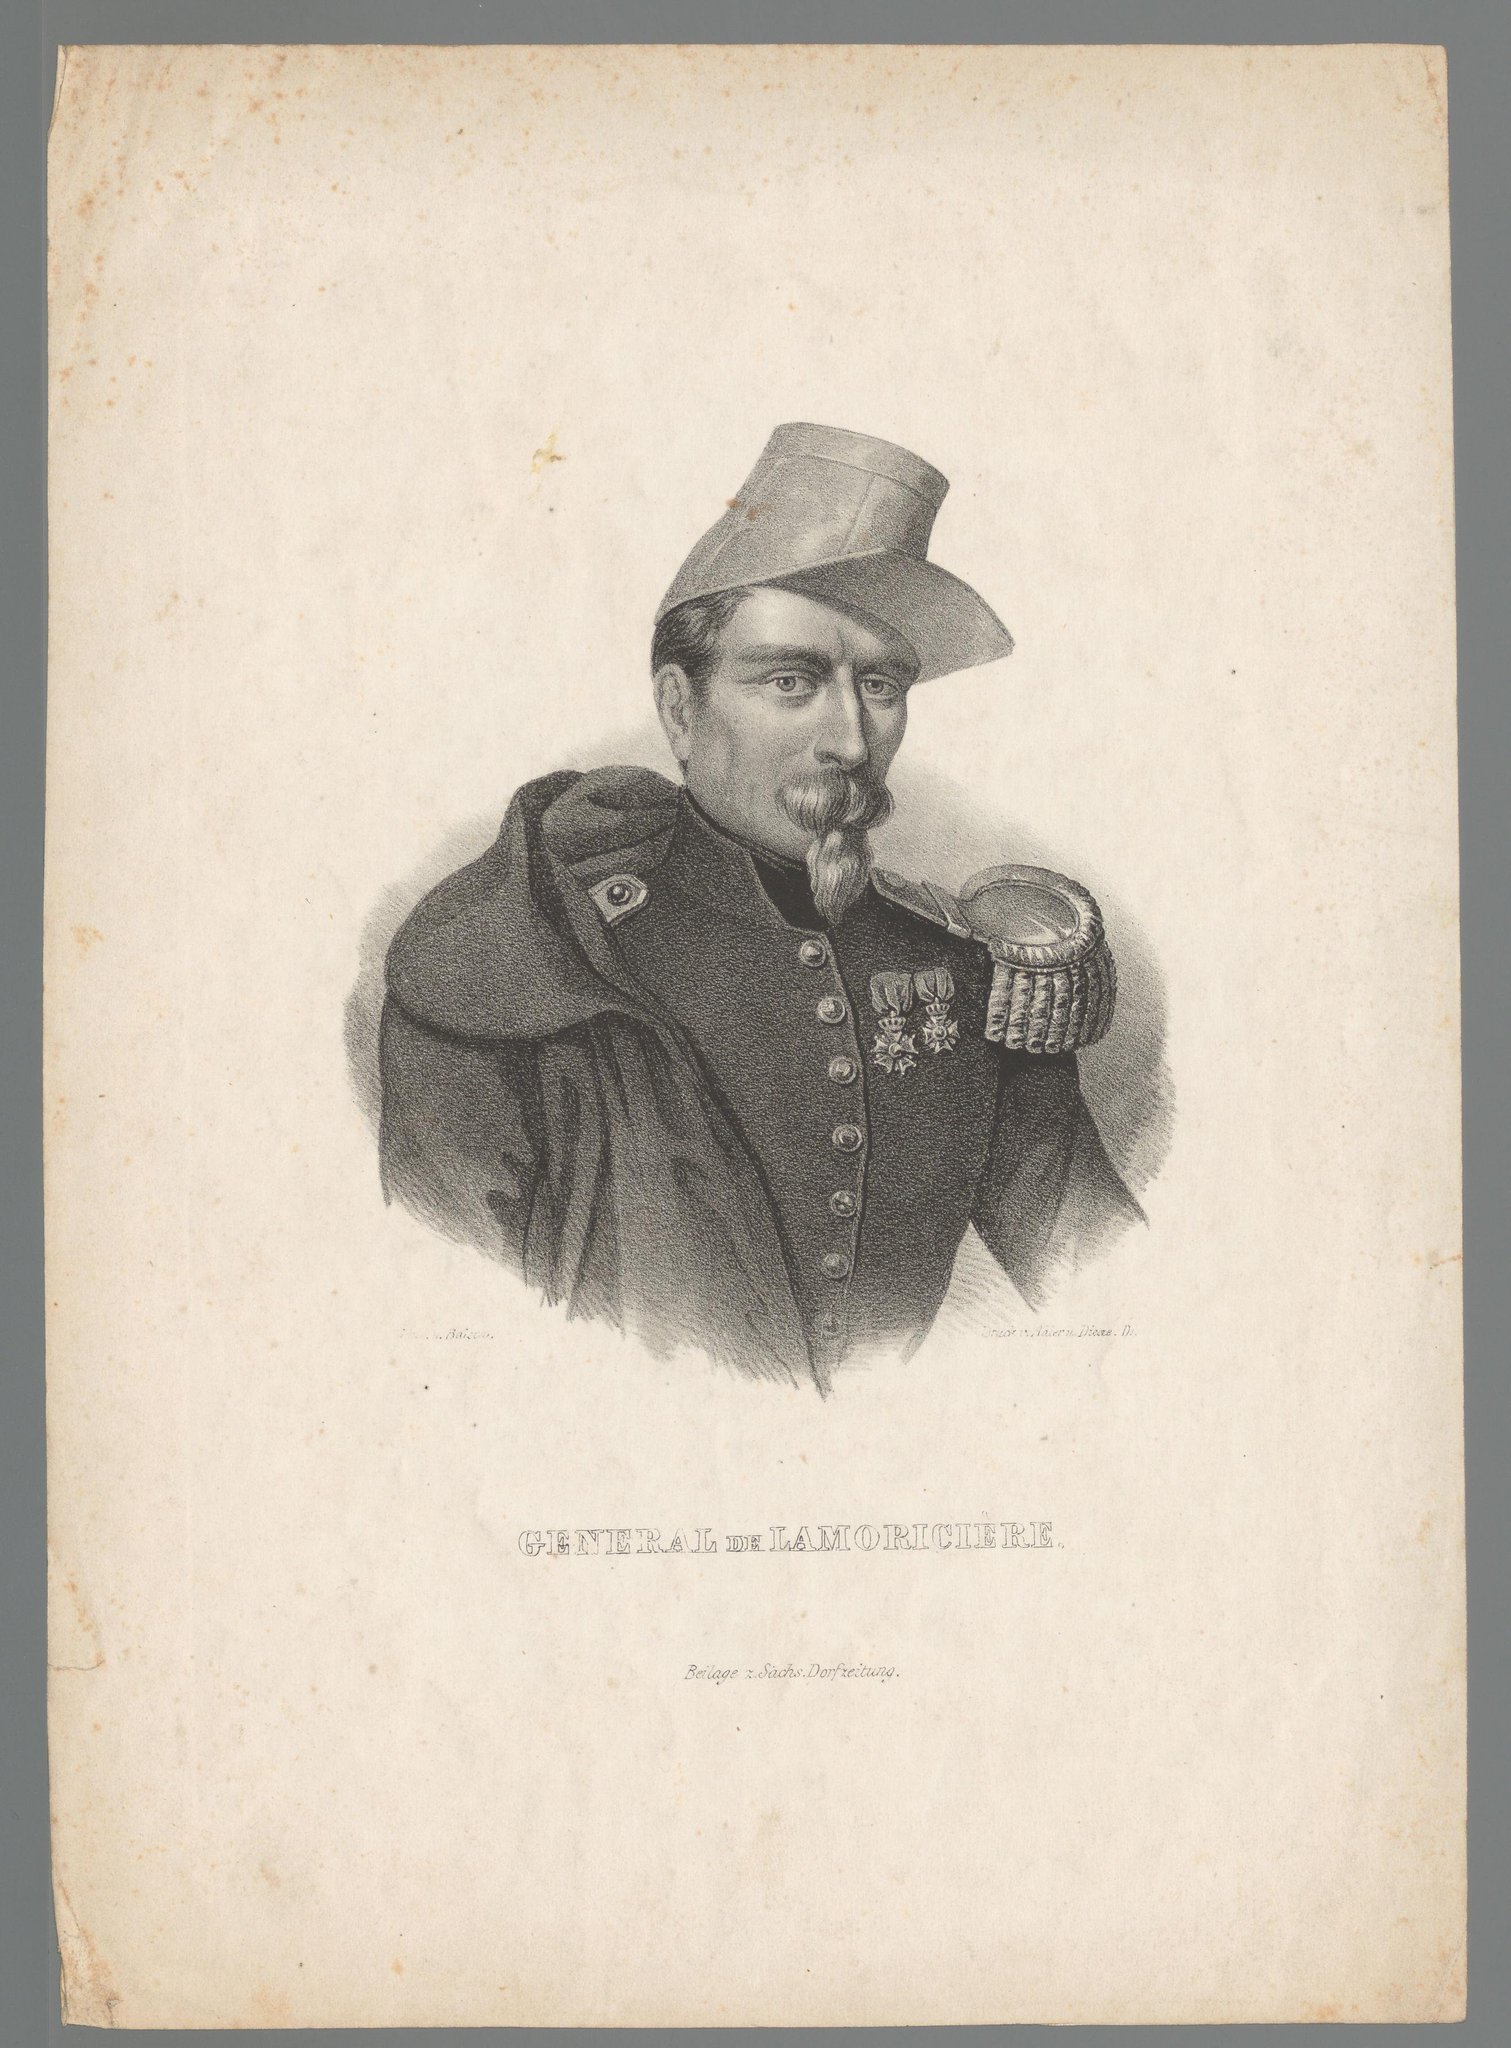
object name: print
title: Portret van Christophe Léon Louis Juchault de Lamoricière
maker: wilhelm heinrich gottlieb baisch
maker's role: print maker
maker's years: 1805-1864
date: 1815-1864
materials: paper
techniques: lithograph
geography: dresden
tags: historical persons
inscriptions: collector's mark: Lugt 2228